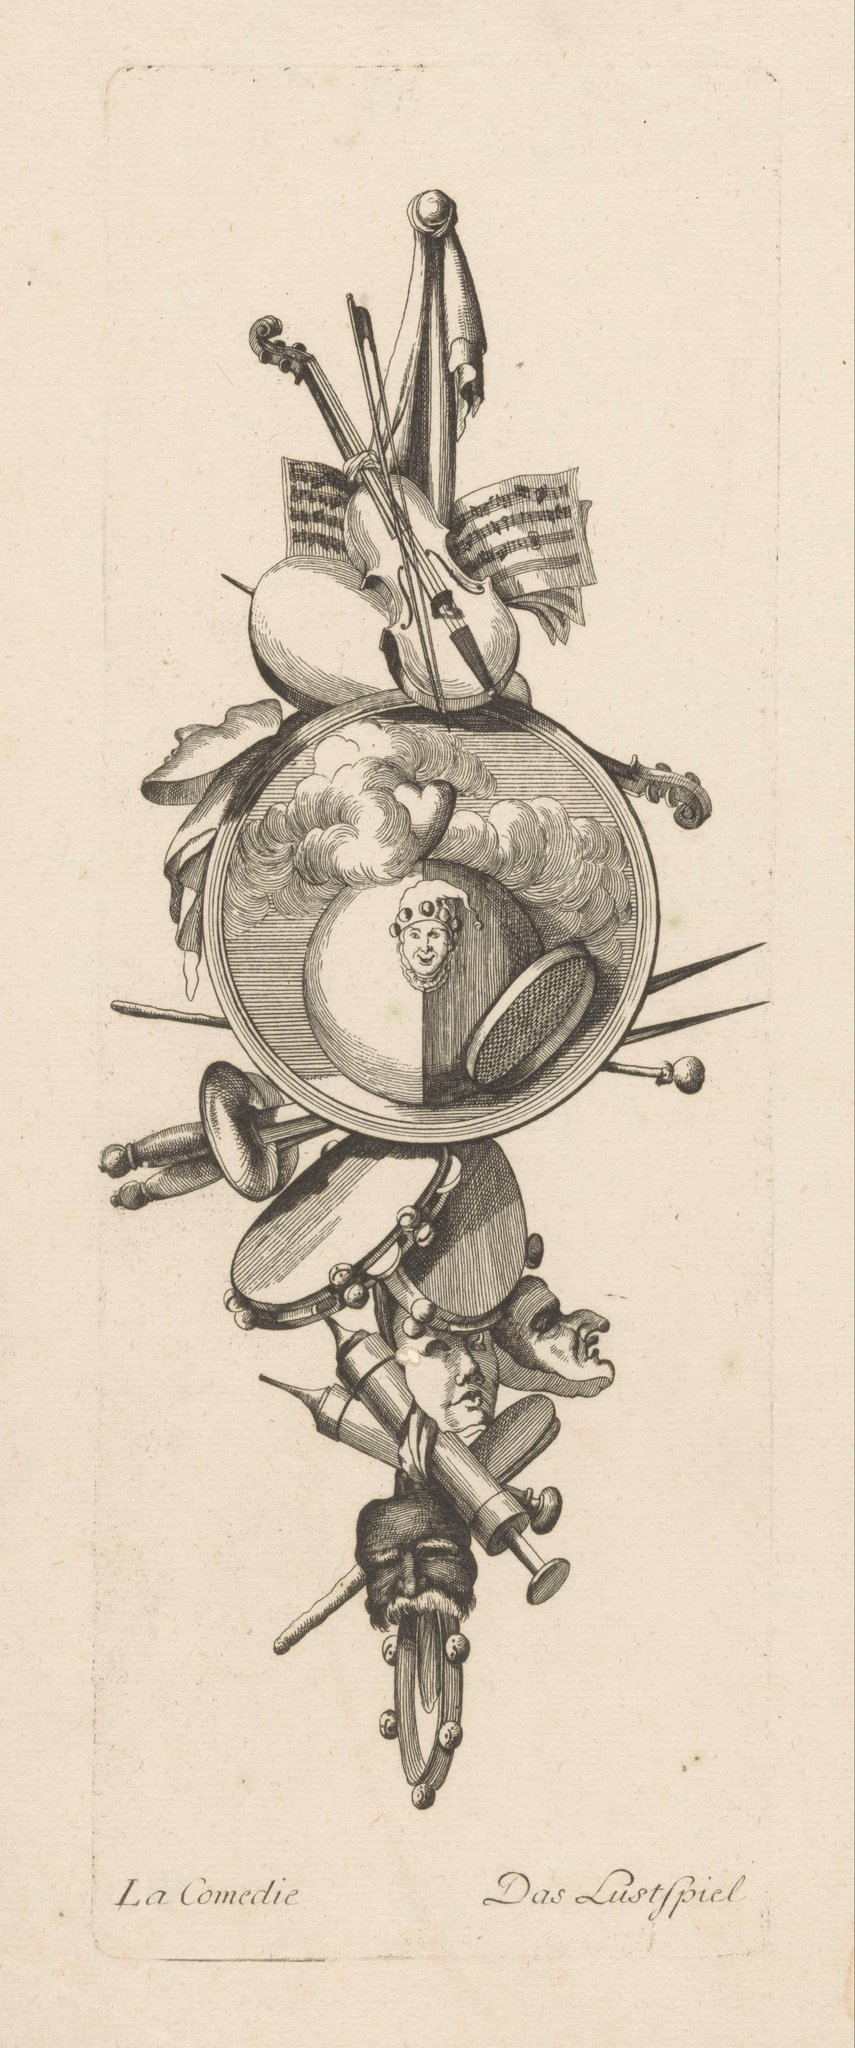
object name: print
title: Komedie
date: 1771-1784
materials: paper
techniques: engraving, etching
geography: augsburg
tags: 'comedia', 'comedia vecchia' (ripa), trophy, i.e.: decorative arrangement of symbolic or typical objects ~ ornament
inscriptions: collector's mark: Lugt 2760, collector's mark: Lugt 2228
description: Een trofee met violen, bladmuziek, maskers, wapens, tamboerijnen, spuiten en een rond medaillon met een zwart-witte bol met een narrenkop.